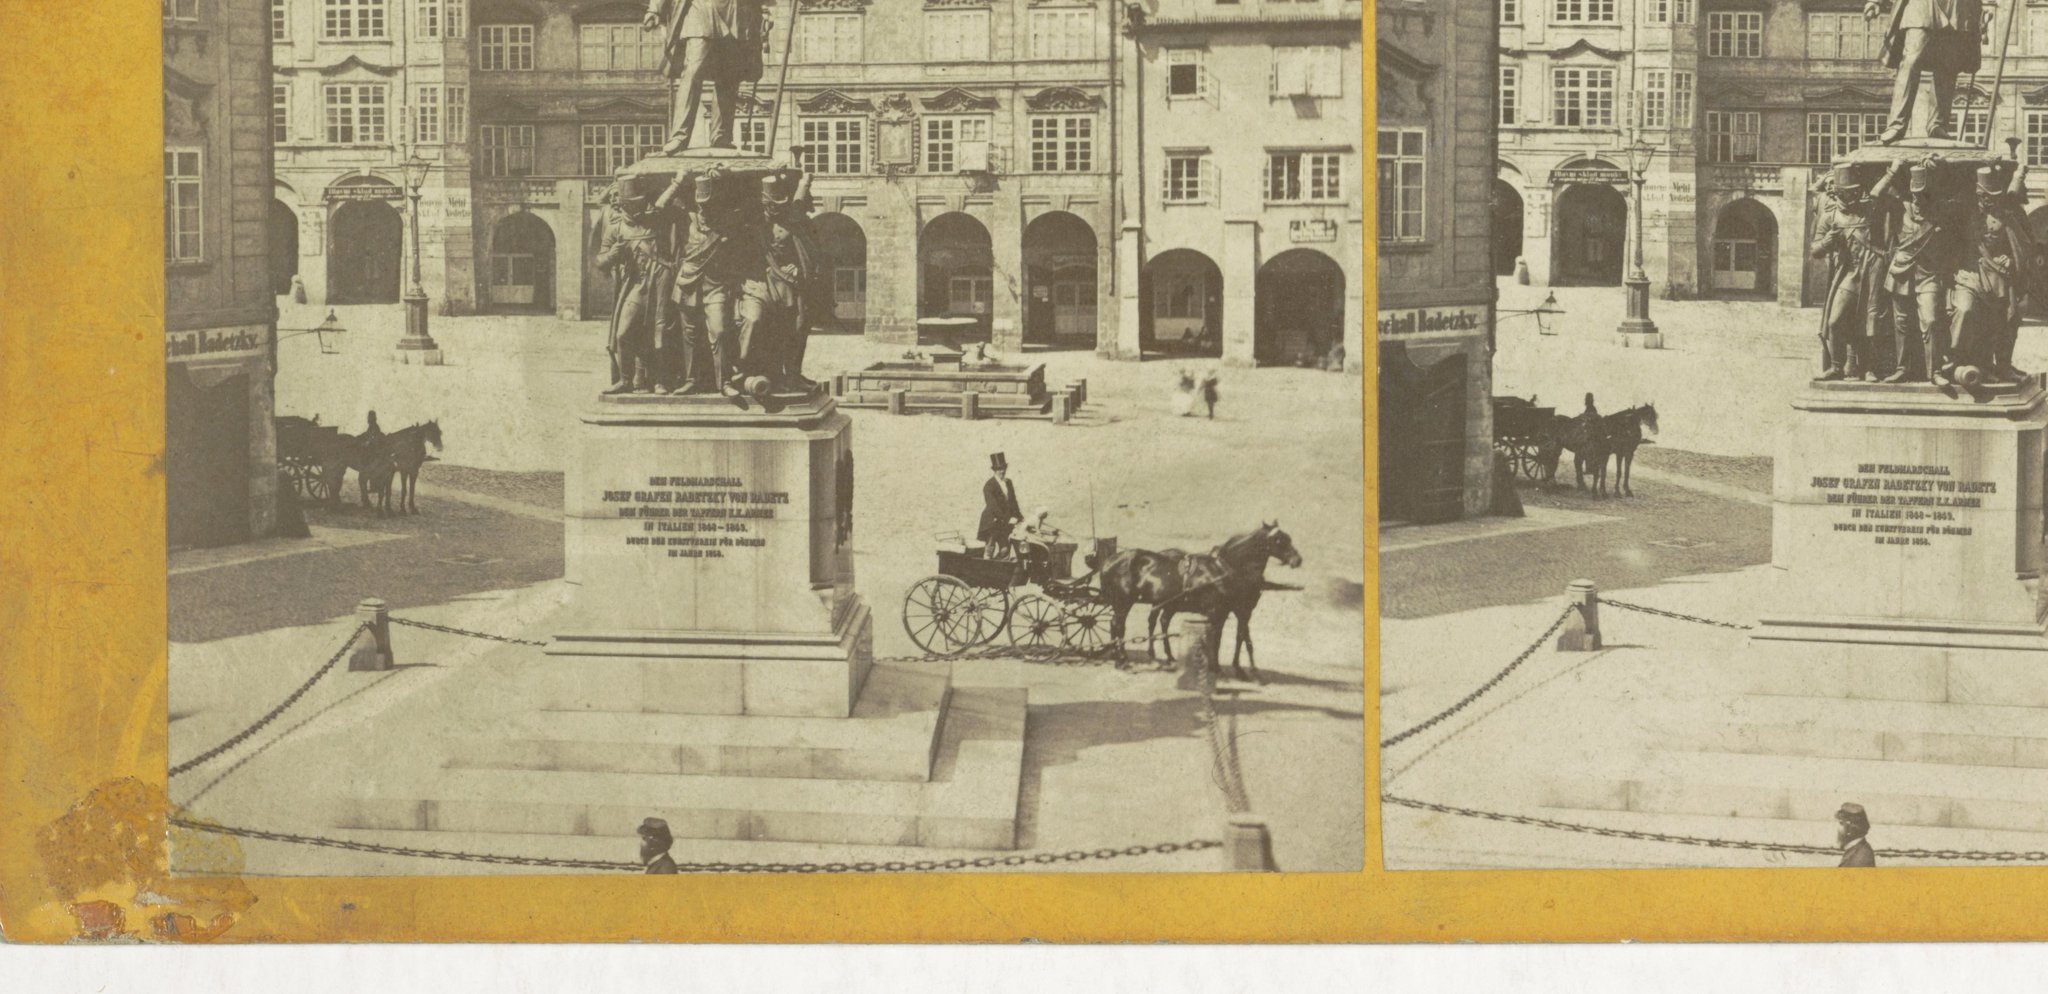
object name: stereograph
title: Radetzkymonument op de Malostranské náměstí, Praag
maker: františek fridrich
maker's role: publisher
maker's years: 1829-1892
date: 1855-1868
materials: cardboard, paper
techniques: albumen print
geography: prague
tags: monument, statue, prague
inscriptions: inscription: ‘K. Pr. Hoffotograf’, retailer's mark: ‘Zur Stadt Paris 596/ 1’, number: ‘33.’, inscription: ‘4322/ 25 of 2.75.’